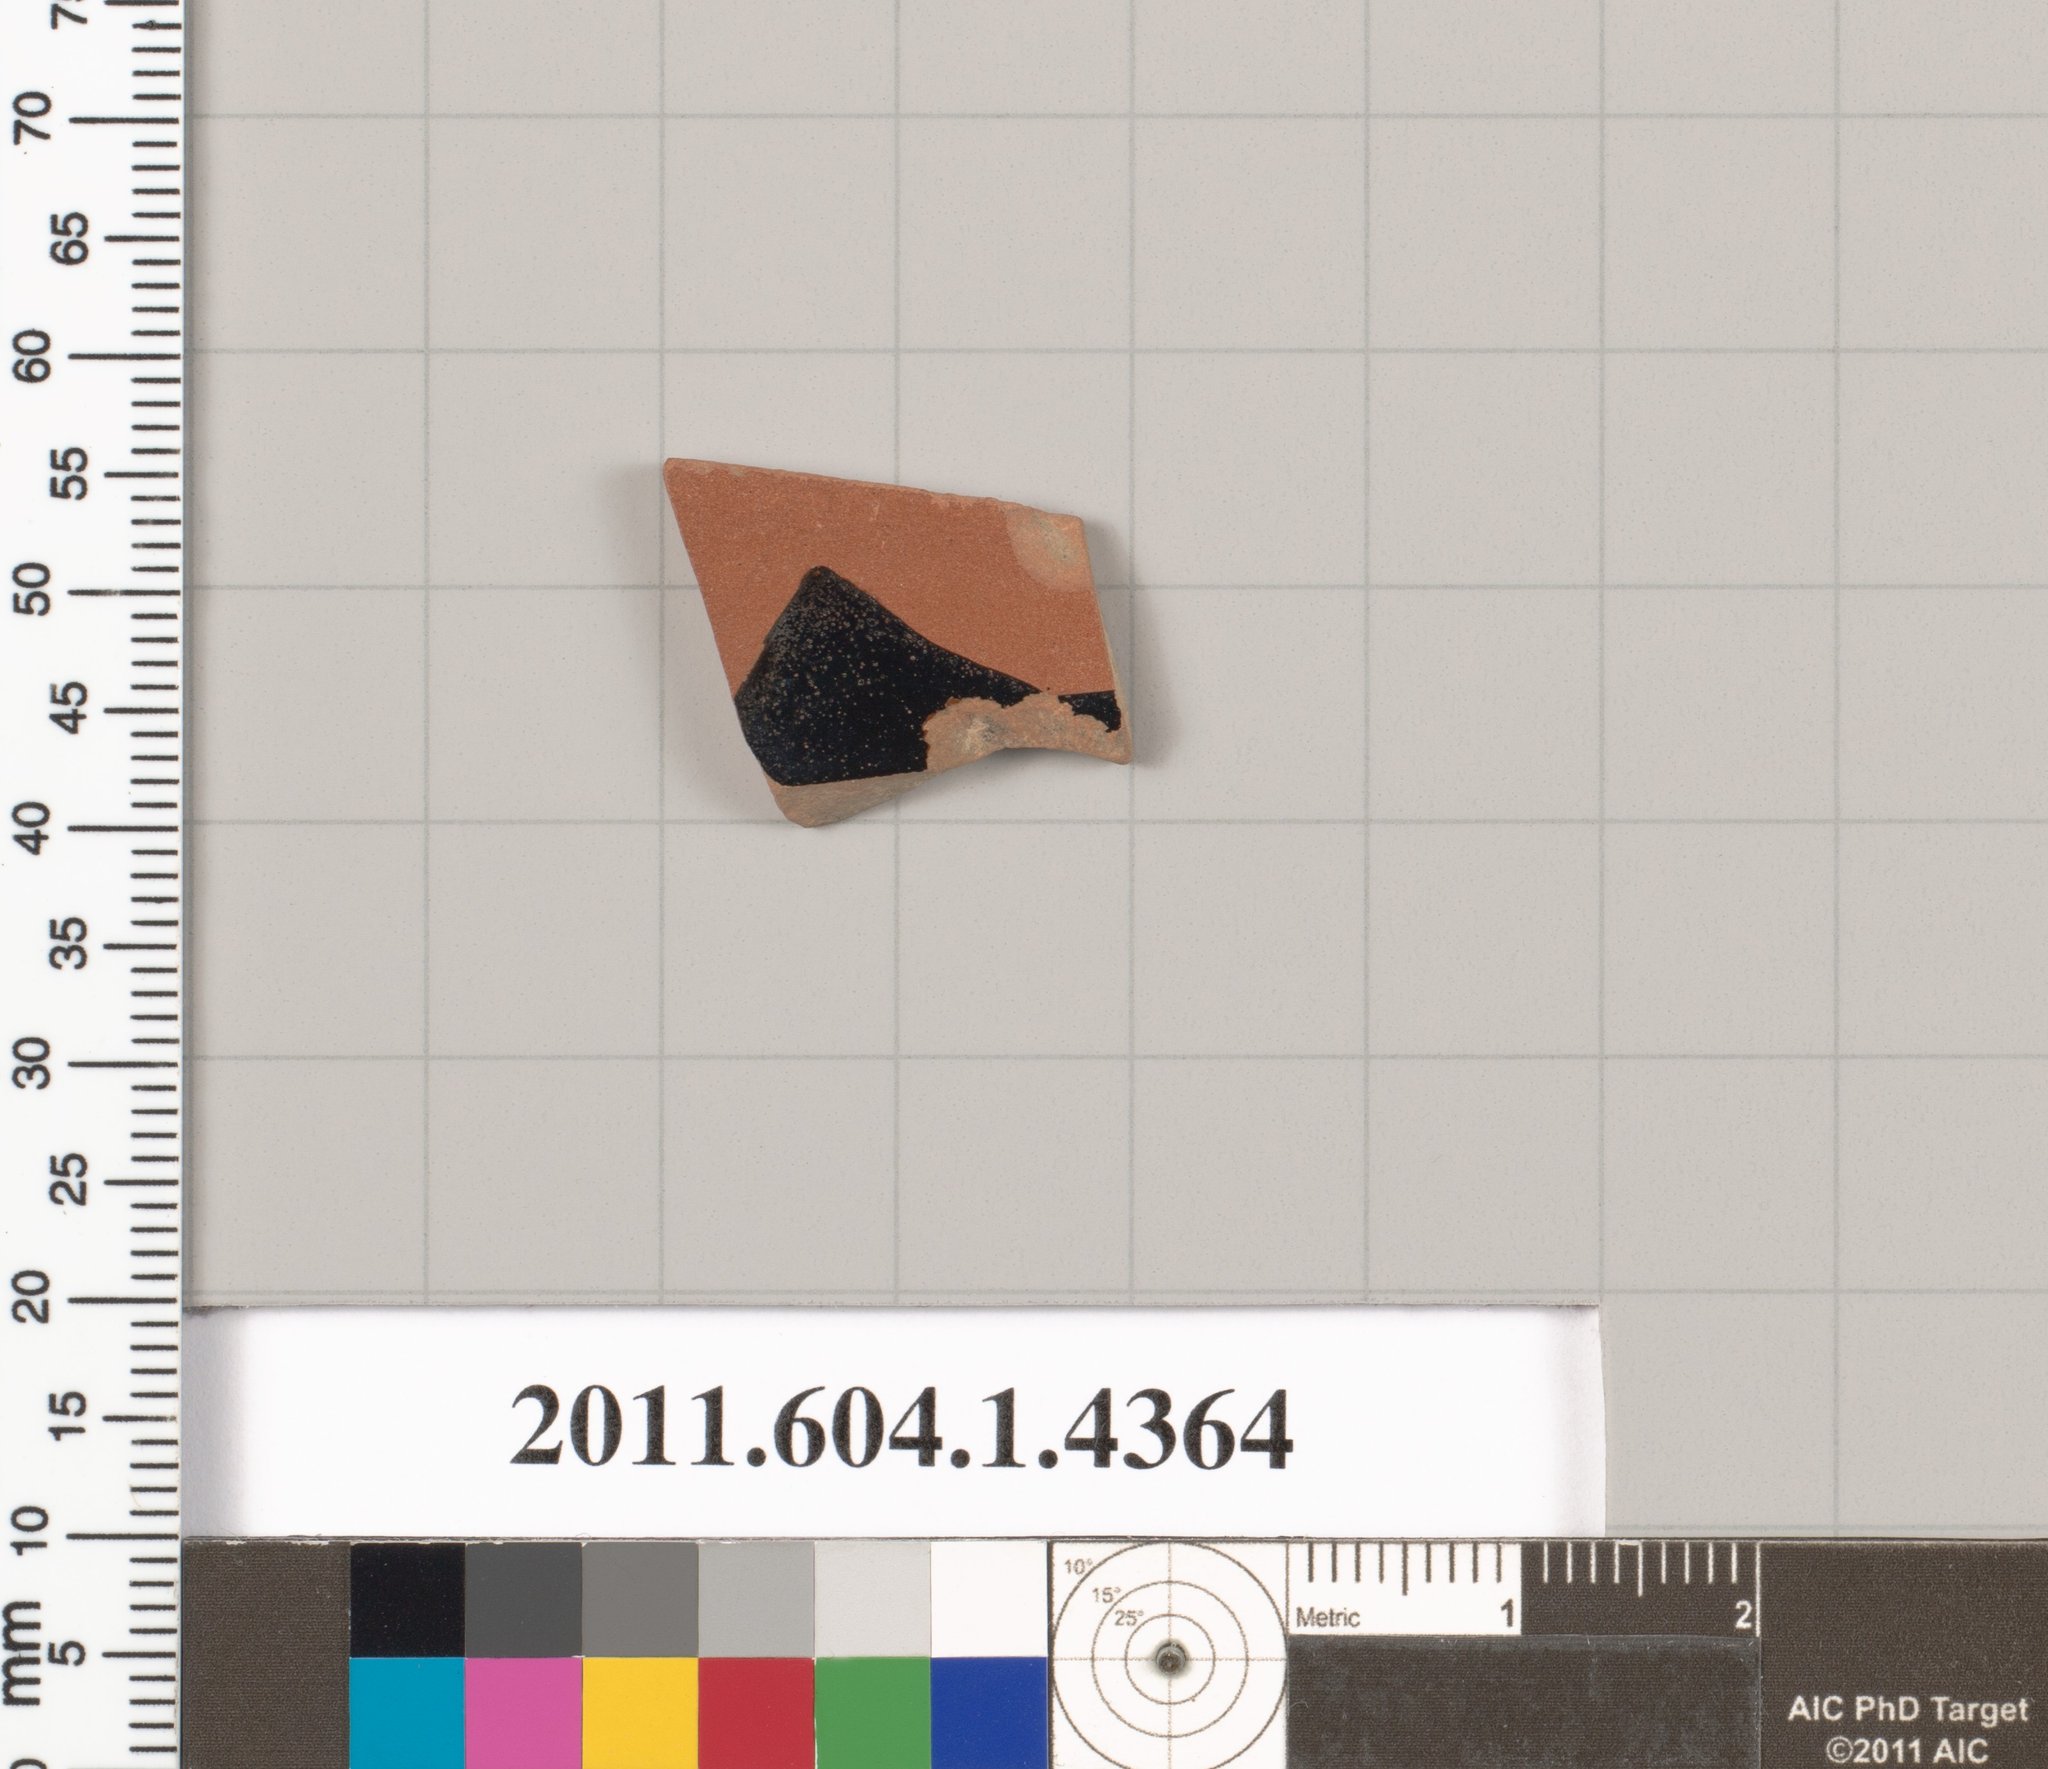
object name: kylix fragment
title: Terracotta fragment of a kylix (drinking cup)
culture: greek, attic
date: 490-470 BCE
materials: terracotta